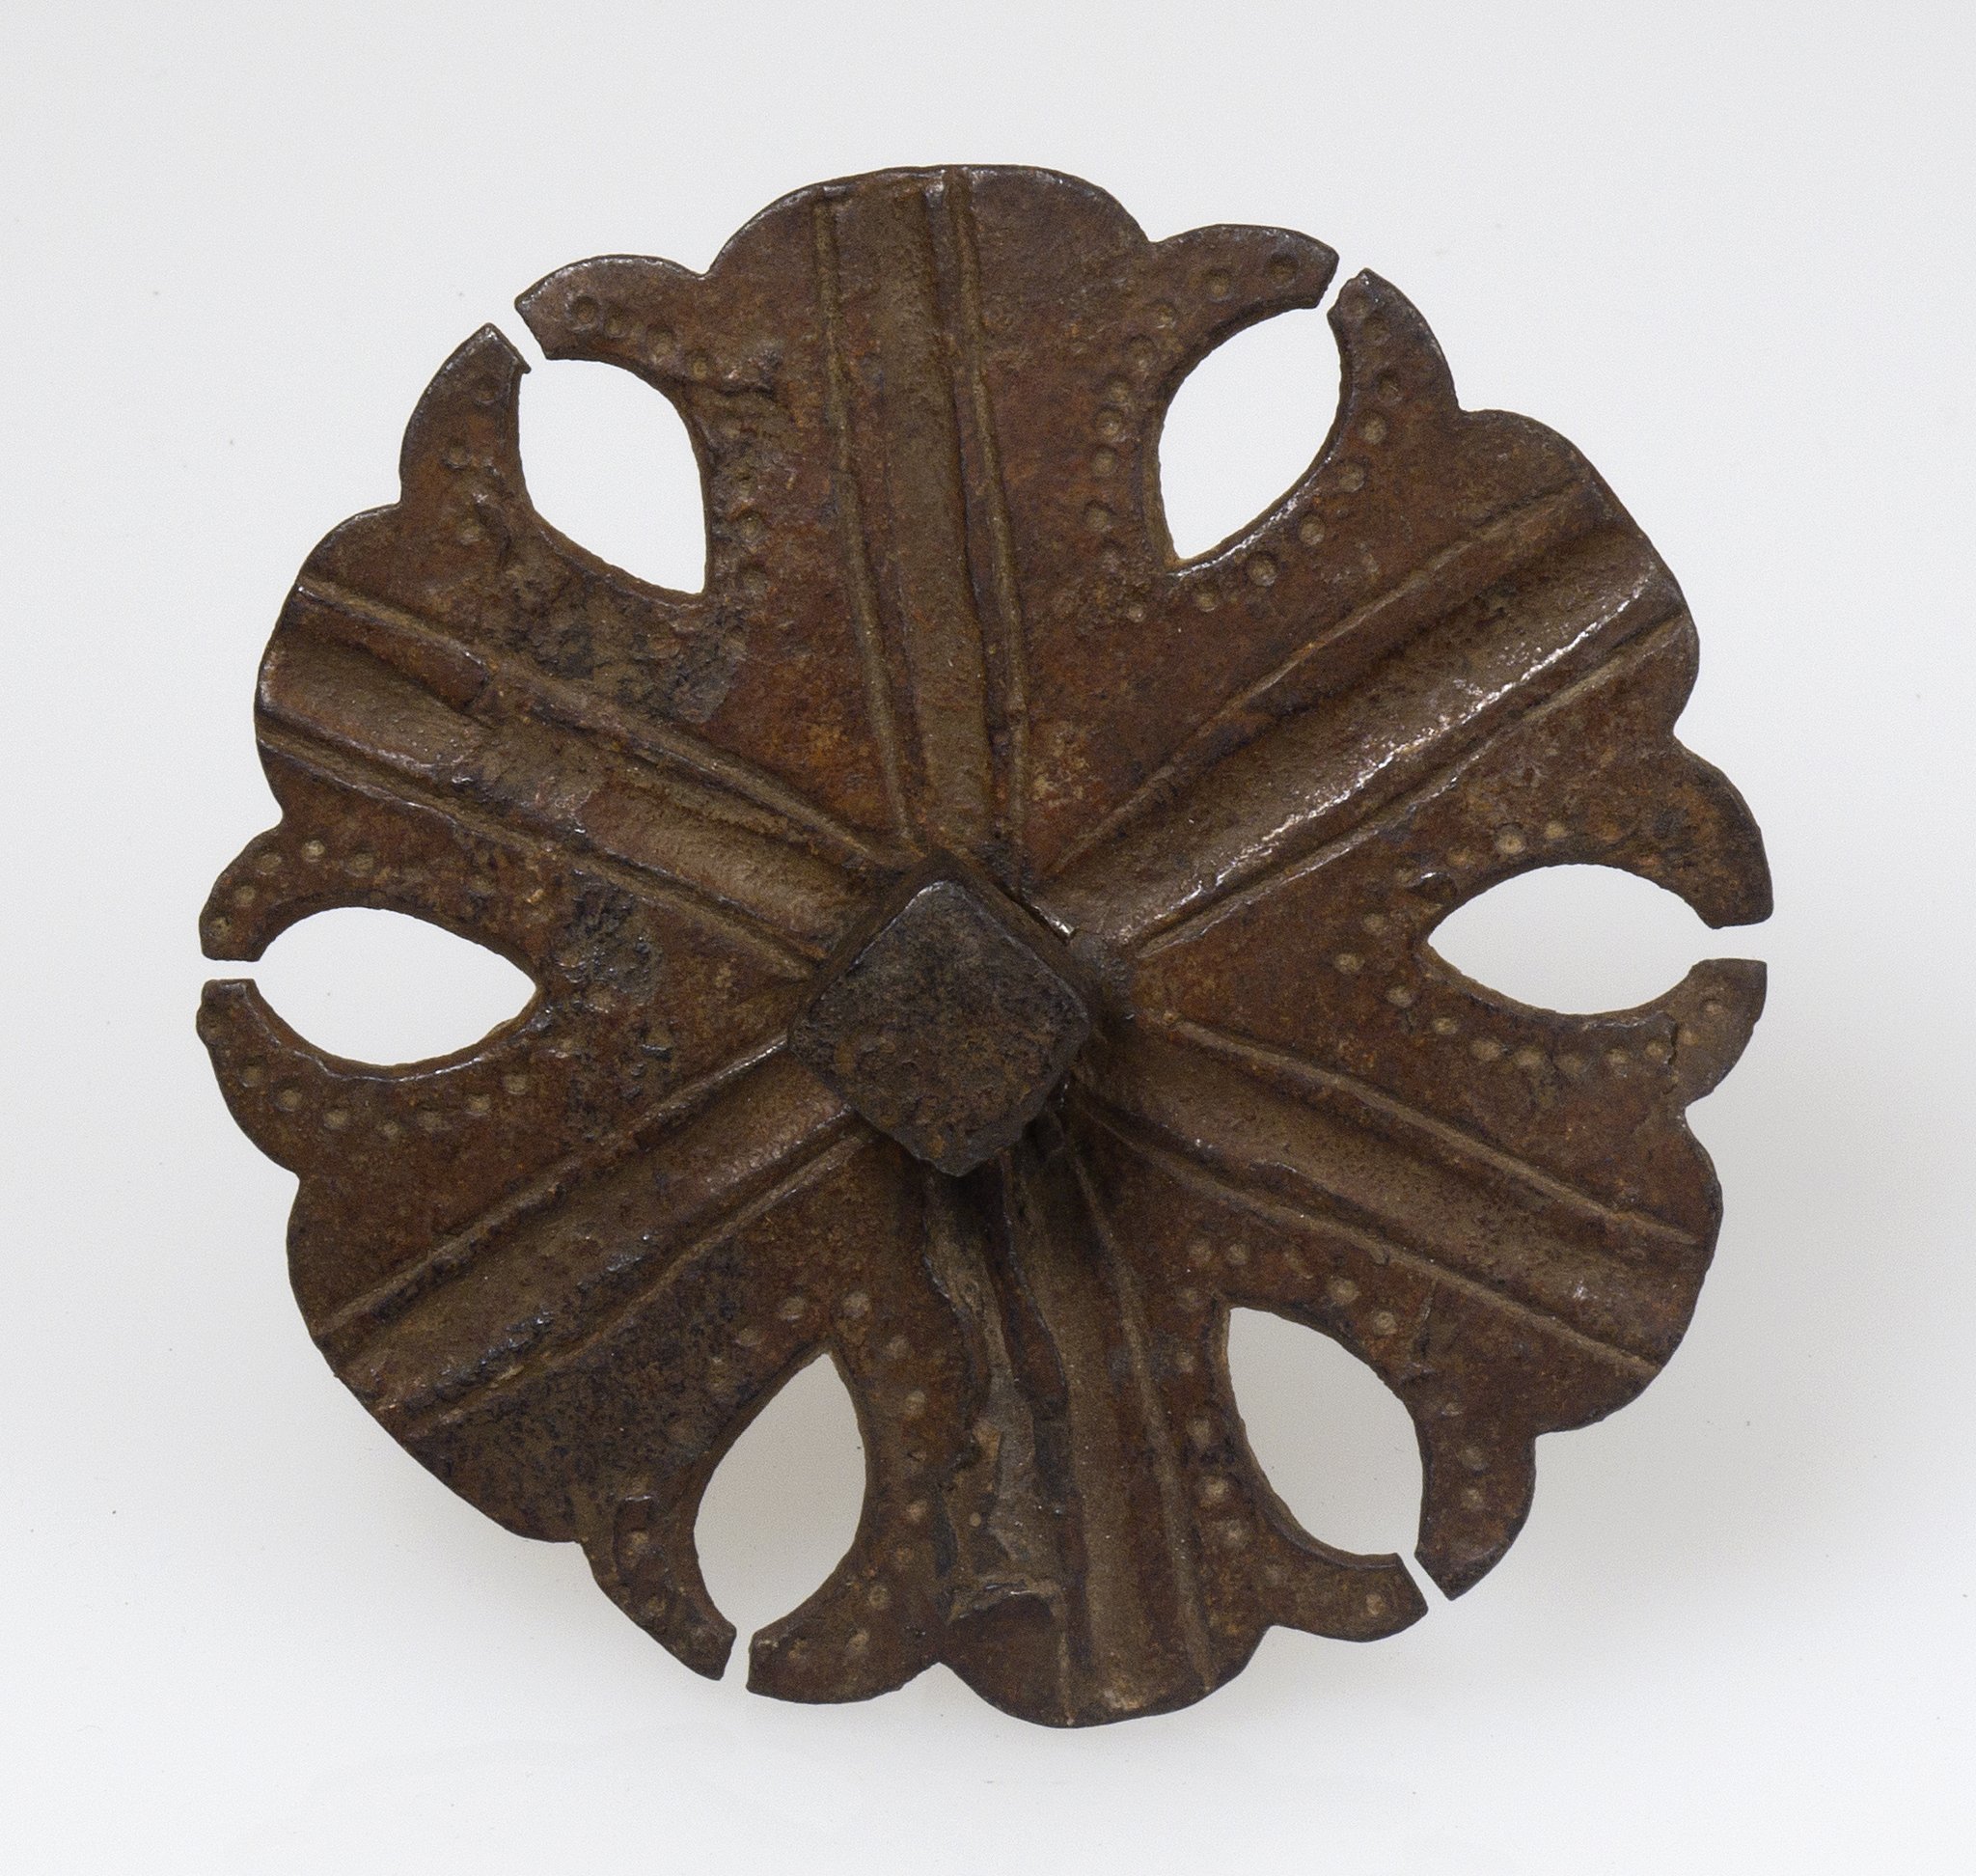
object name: plate and nail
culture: european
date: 1401-1600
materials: iron